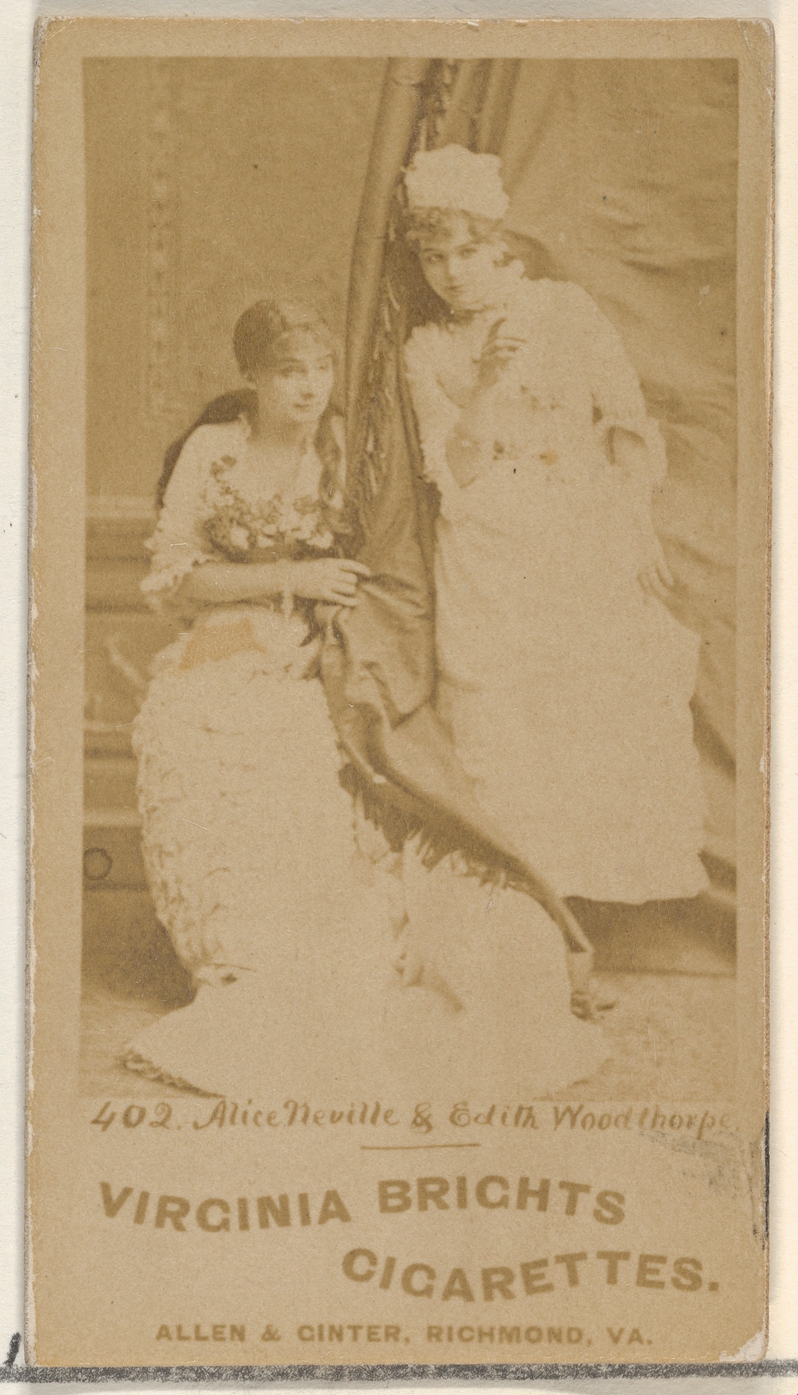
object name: photograph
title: Card 402, Alice Neville and Edith Woodthorpe, from the Actors and Actresses series (N45, Type 1) for Virginia Brights Cigarettes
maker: allen & ginter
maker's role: publisher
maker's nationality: american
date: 1888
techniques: albumen silver print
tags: portraits,women,actresses